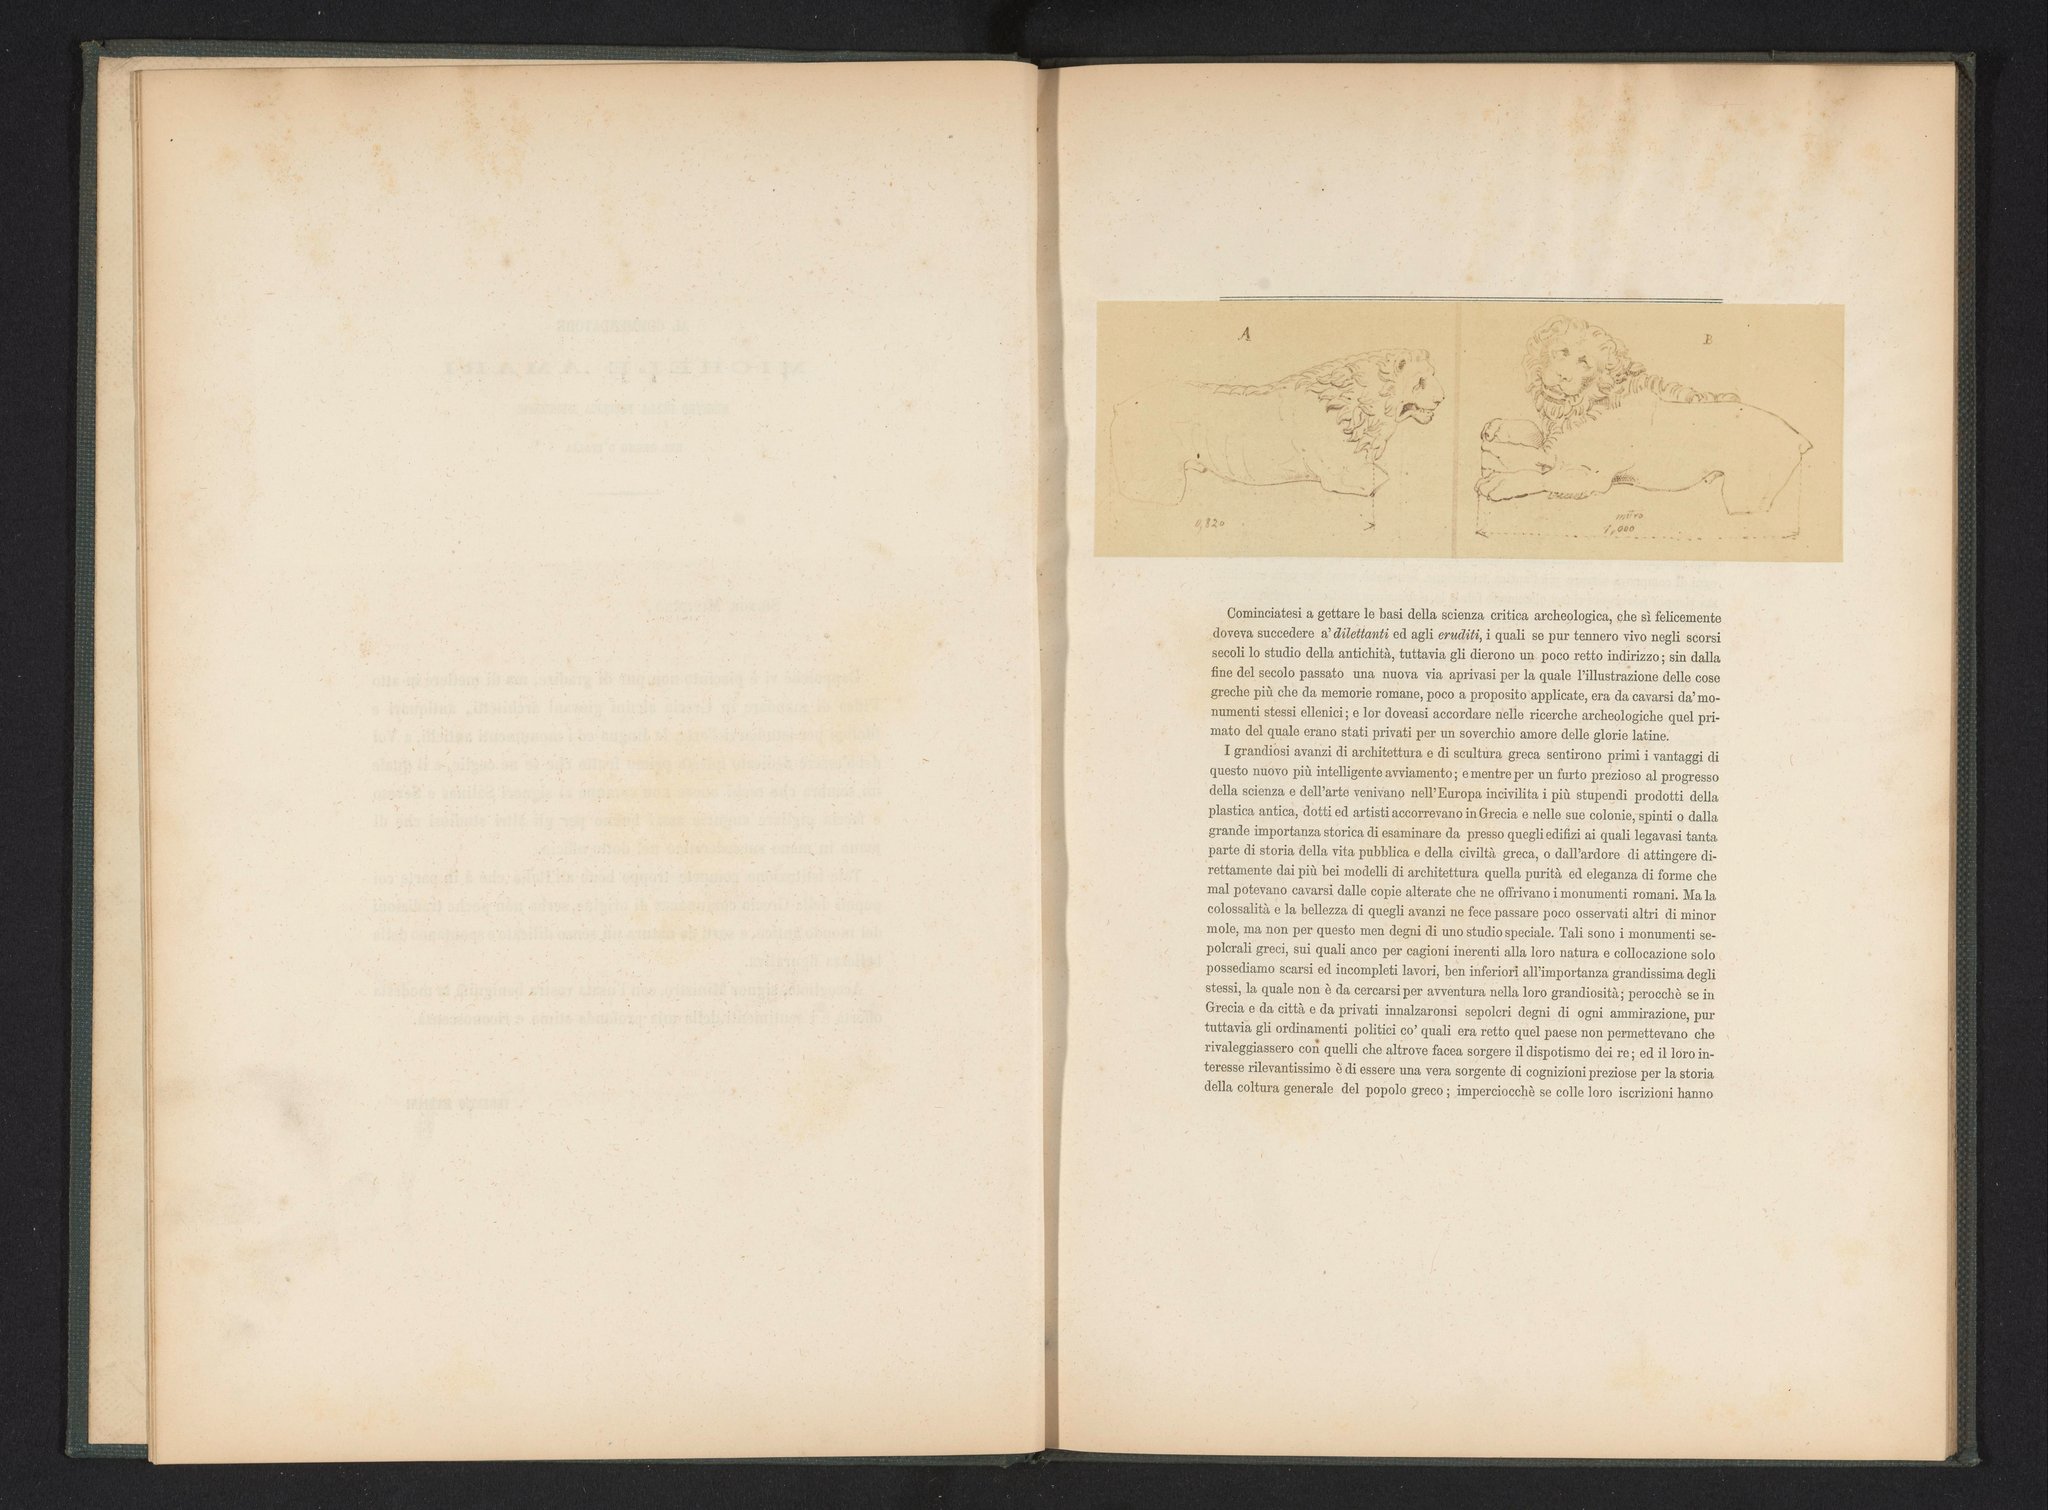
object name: reproduction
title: Fotoreproductie van twee tekeningen van sculpturen van leeuwen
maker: Anonymous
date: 1863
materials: photographic support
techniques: albumen print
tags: sculpture, beasts of prey, predatory animals: lion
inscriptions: inscription: ‘A B’